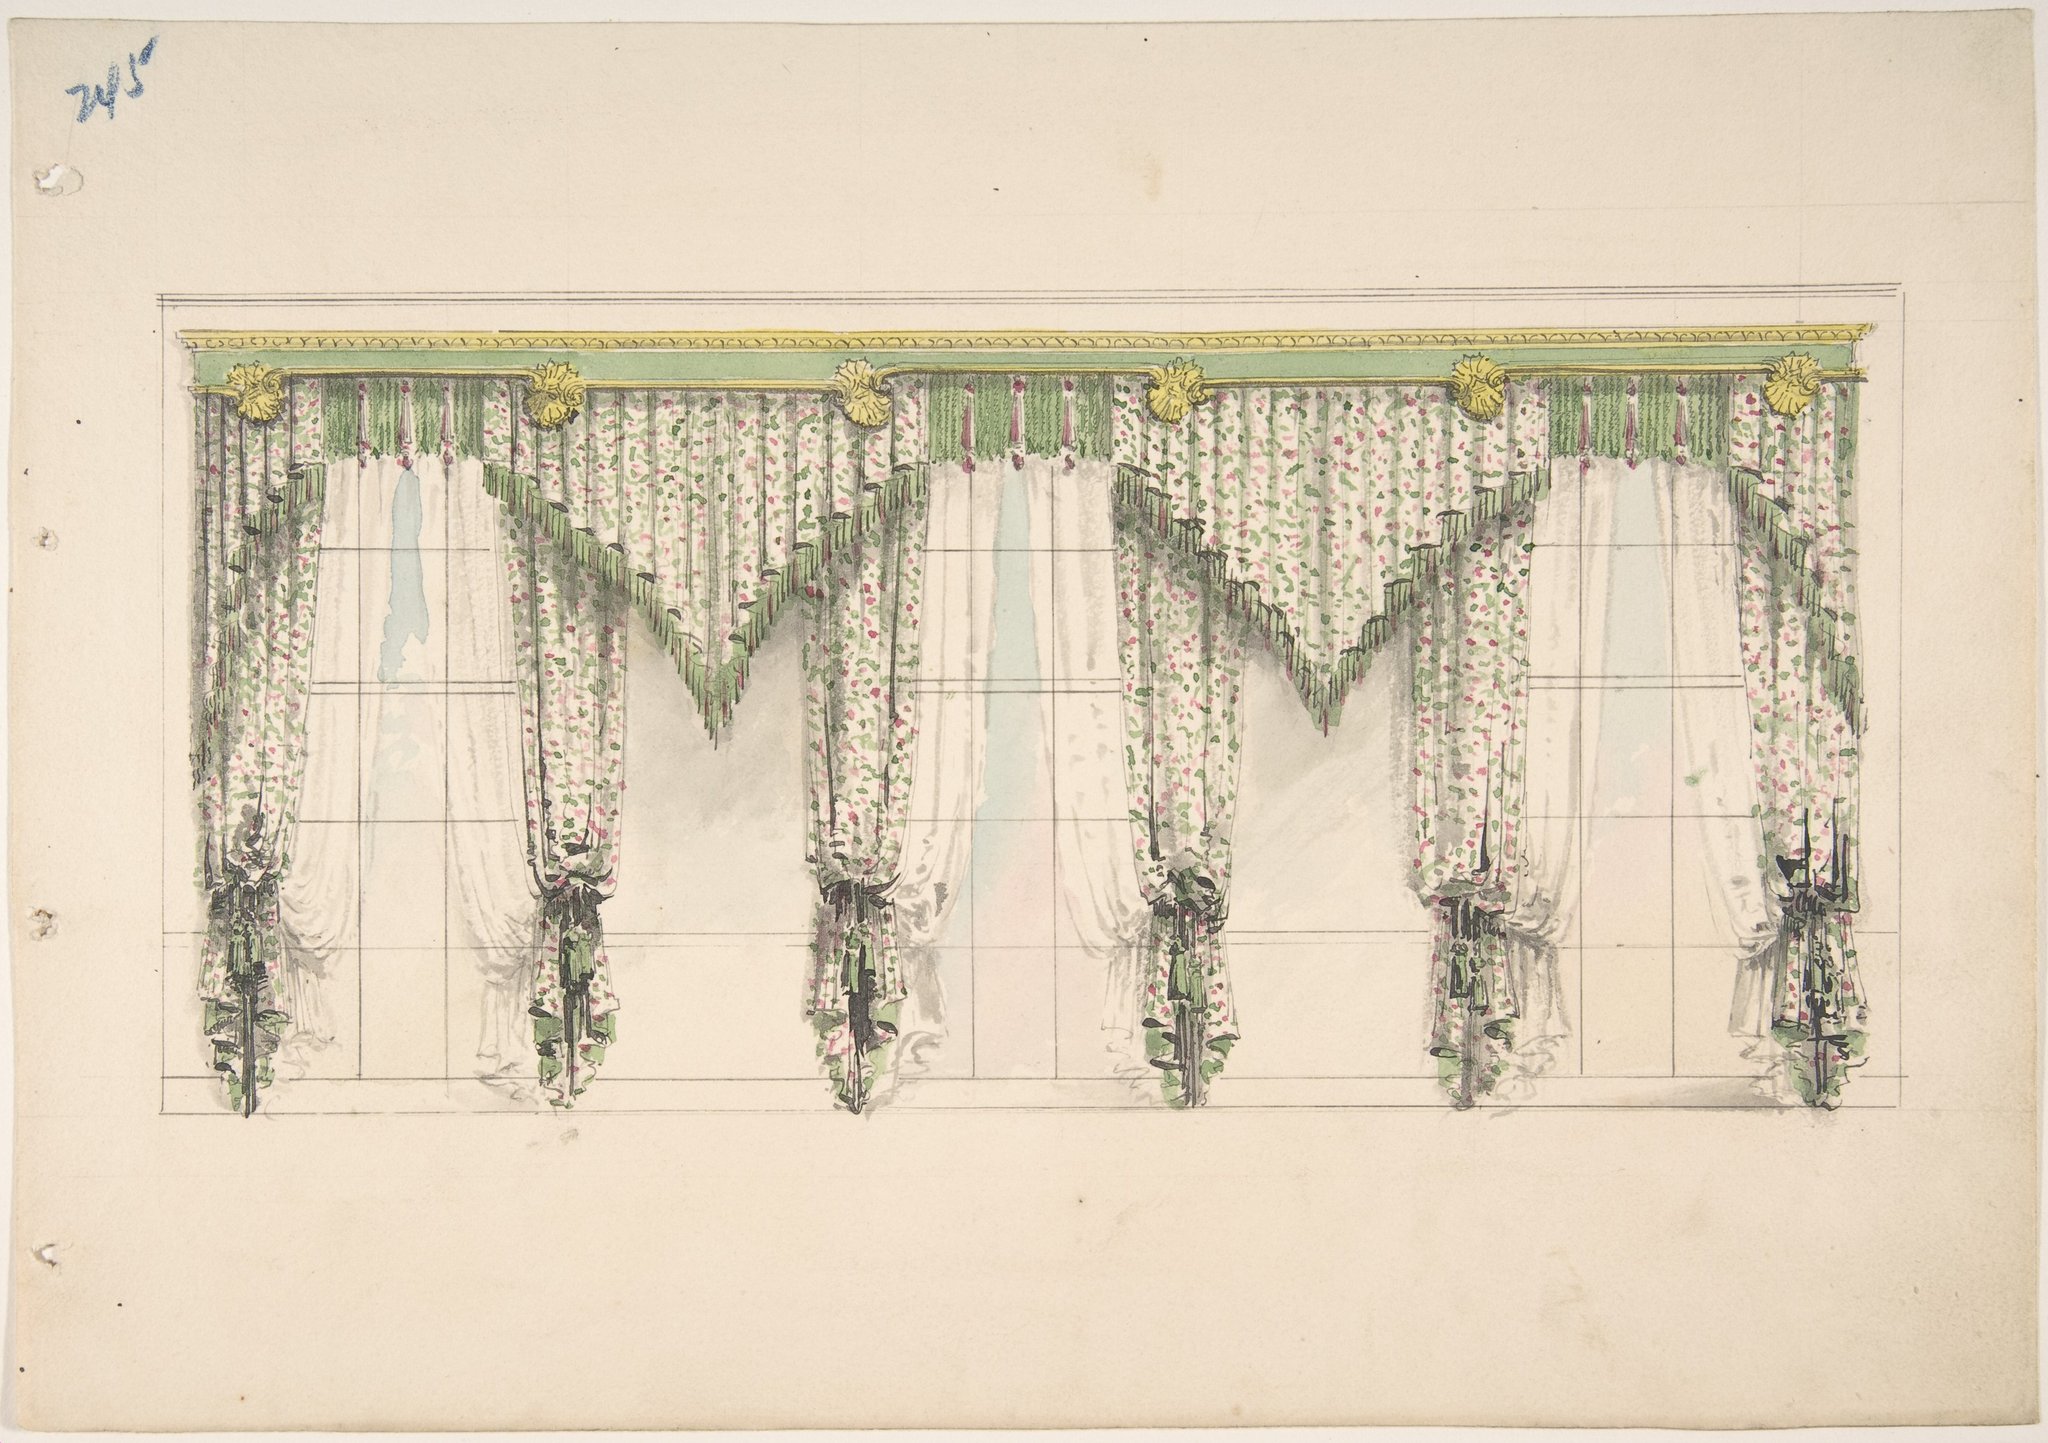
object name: drawing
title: Design for Curtains with Pink, Green and White Floral Fabric and Pink and Green Fringes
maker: anonymous, british, 19th century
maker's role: artist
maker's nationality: british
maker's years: 1800-1900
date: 1820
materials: ink, watercolor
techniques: brush, pen, wash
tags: windows,curtains